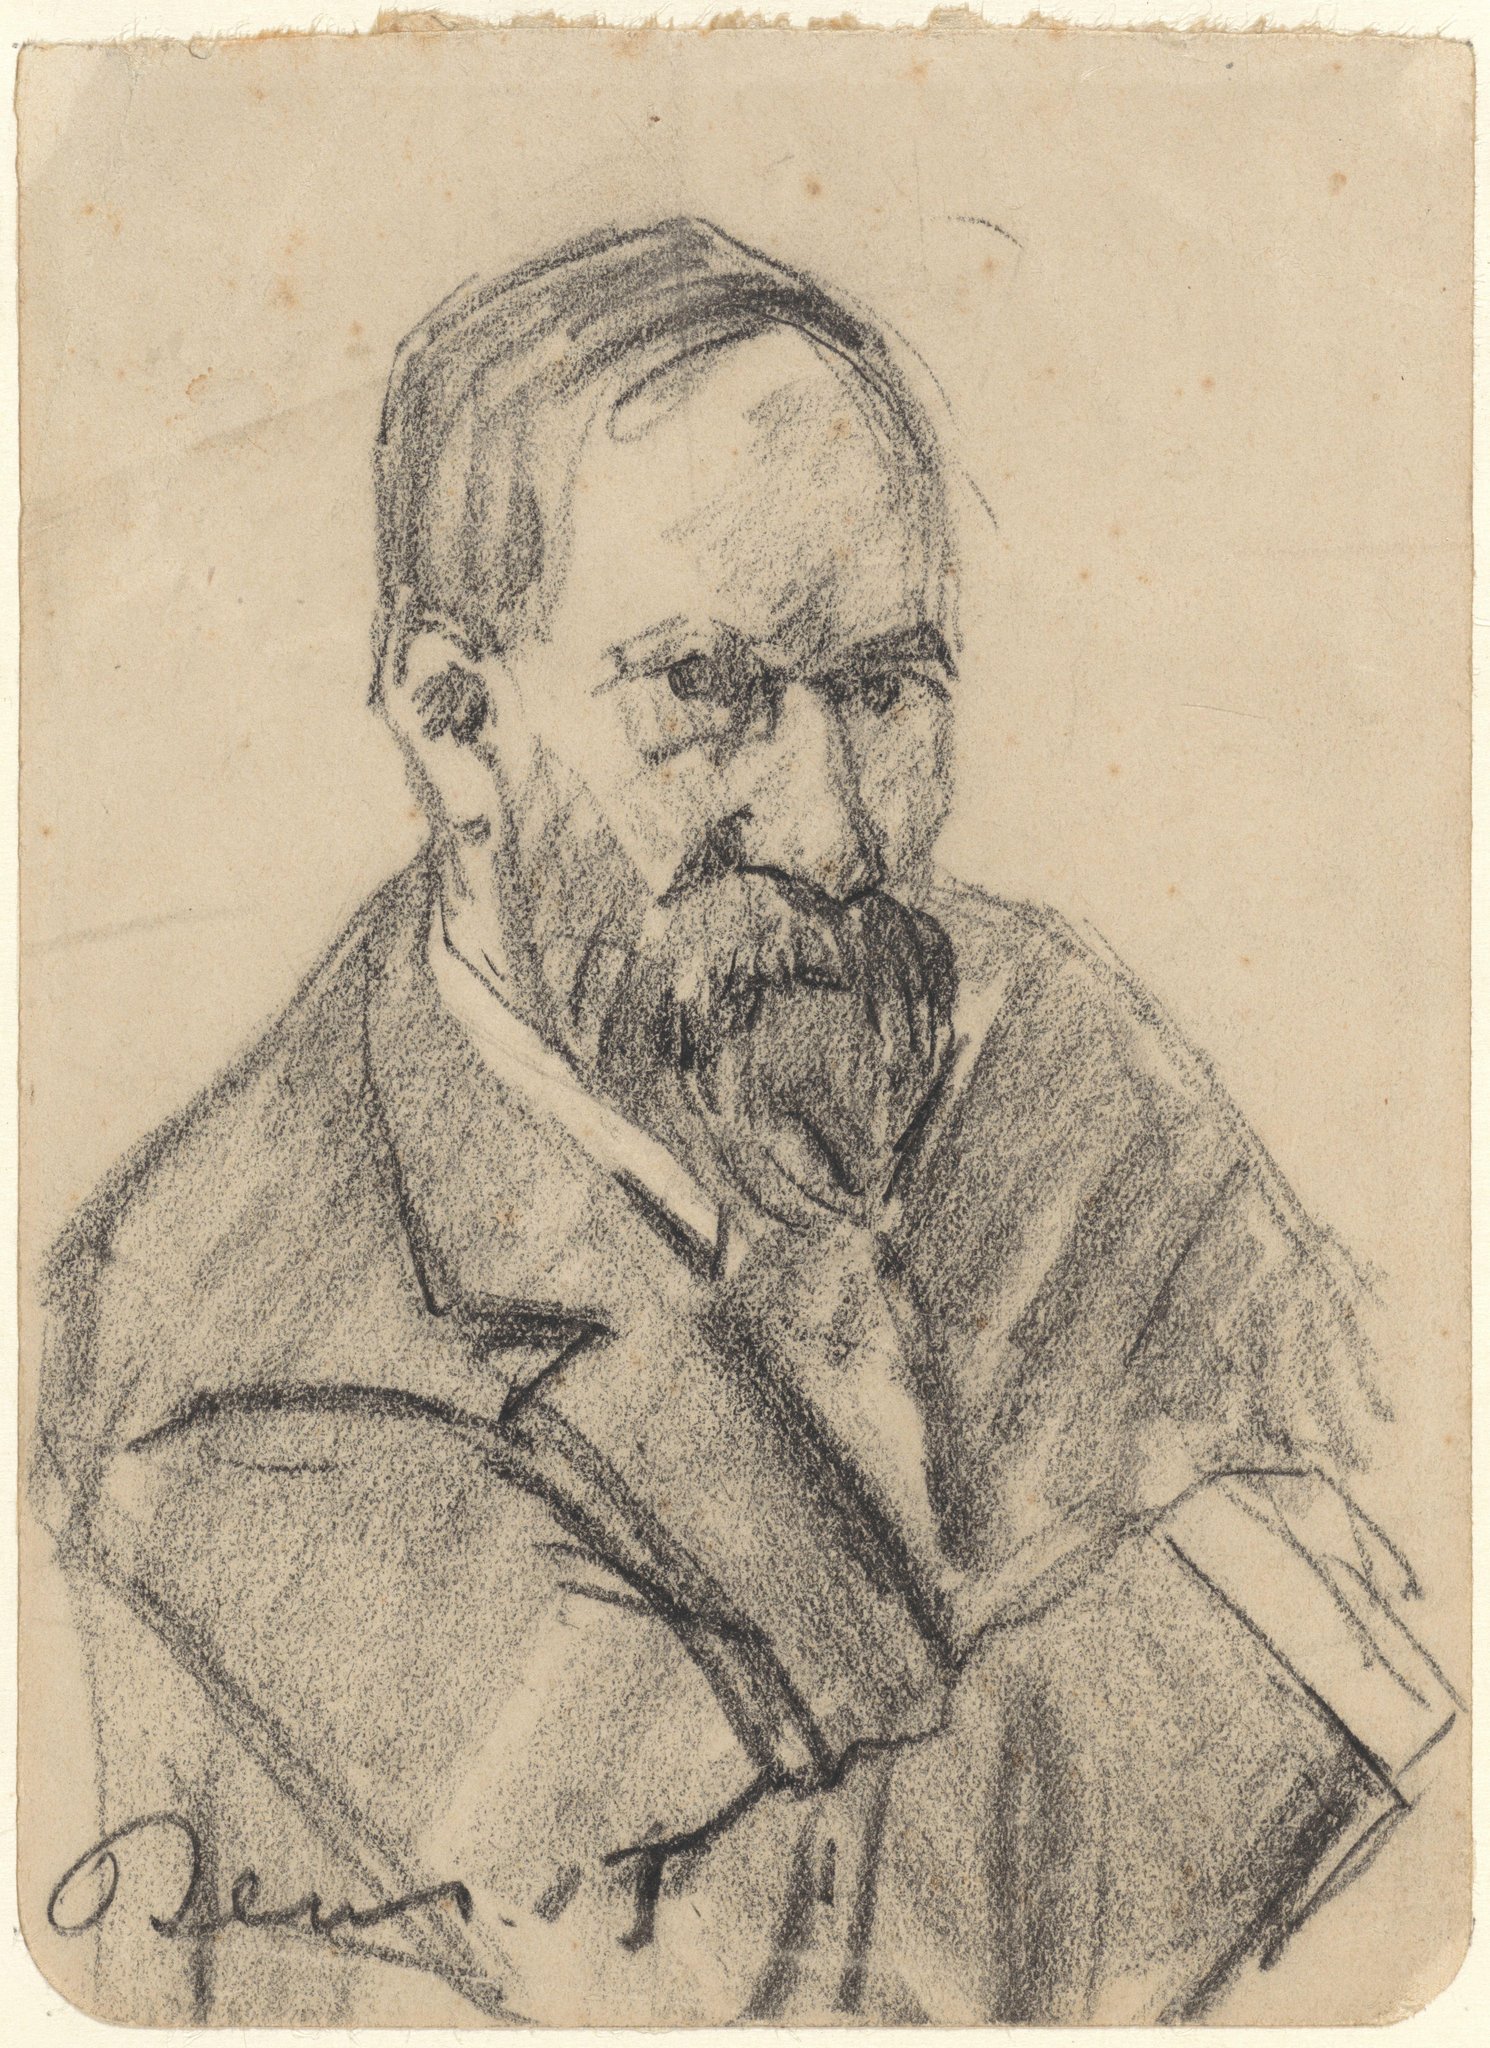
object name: drawing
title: Portret van Willem C. Bauer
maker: rinus reus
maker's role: draughtsman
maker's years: 1865-1938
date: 1875-1938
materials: chalk, paper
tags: historical persons